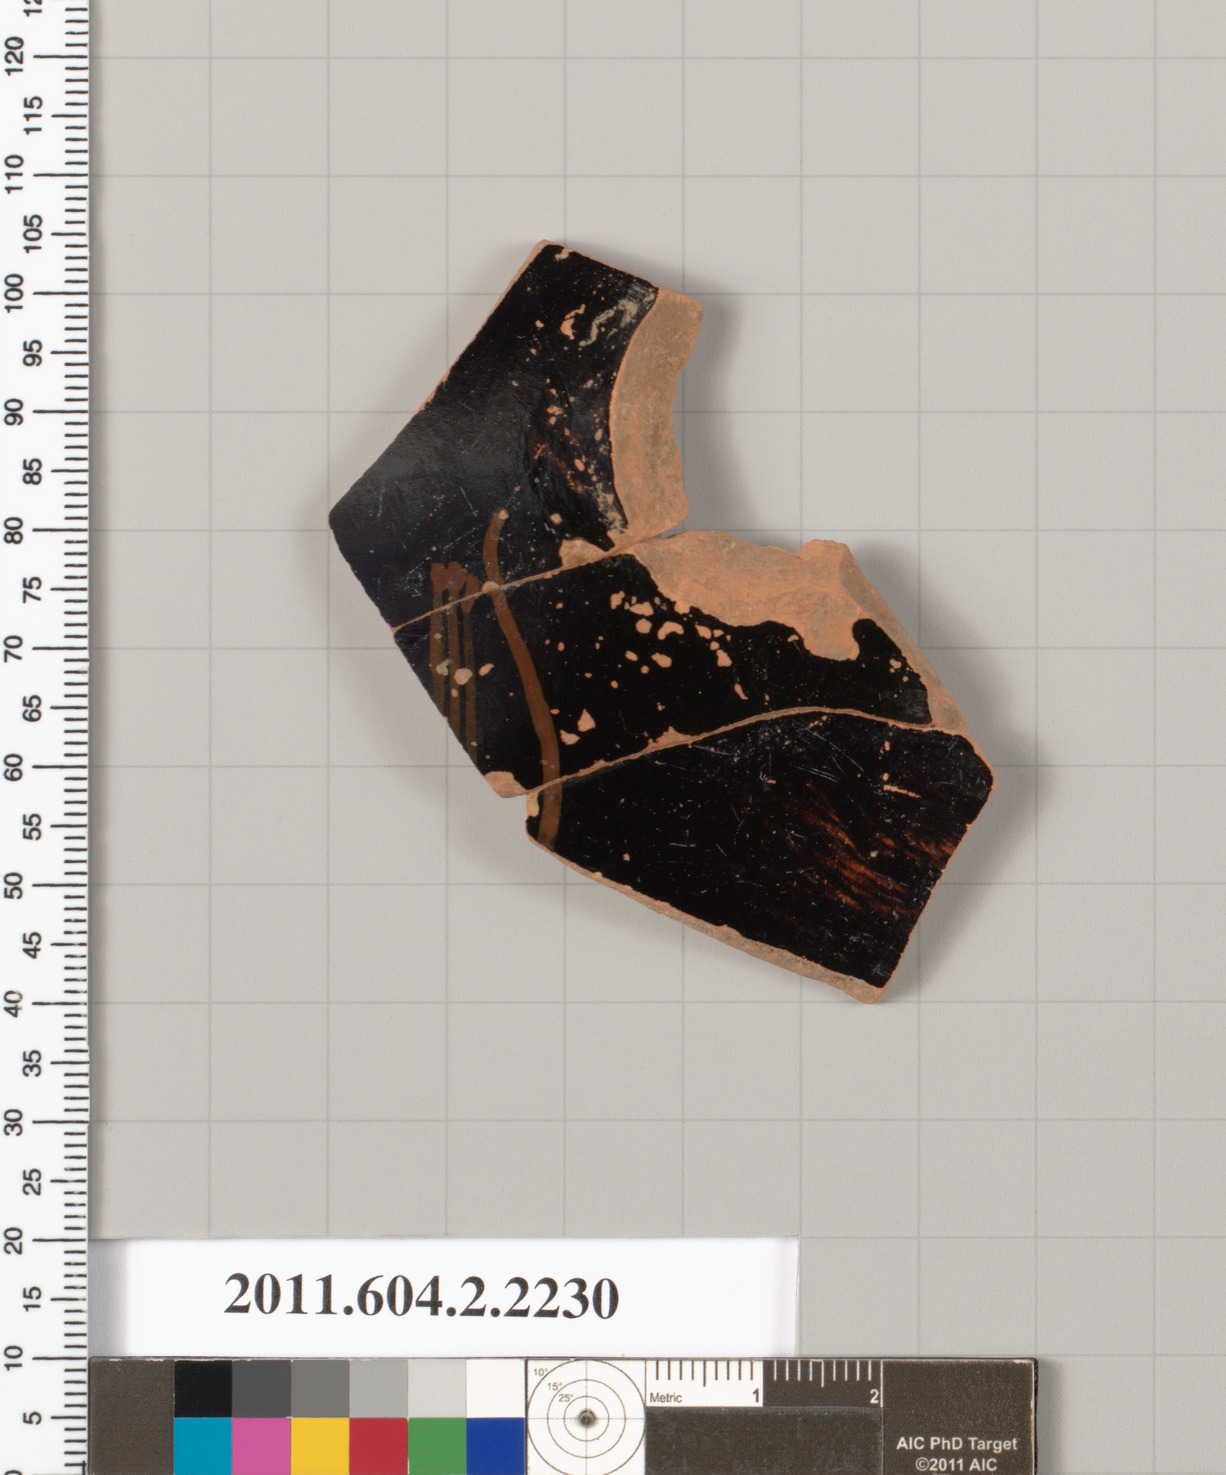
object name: pot fragment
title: Terracotta fragment of a lekythos (oil flask)?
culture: greek, attic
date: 500-451 BCE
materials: terracotta